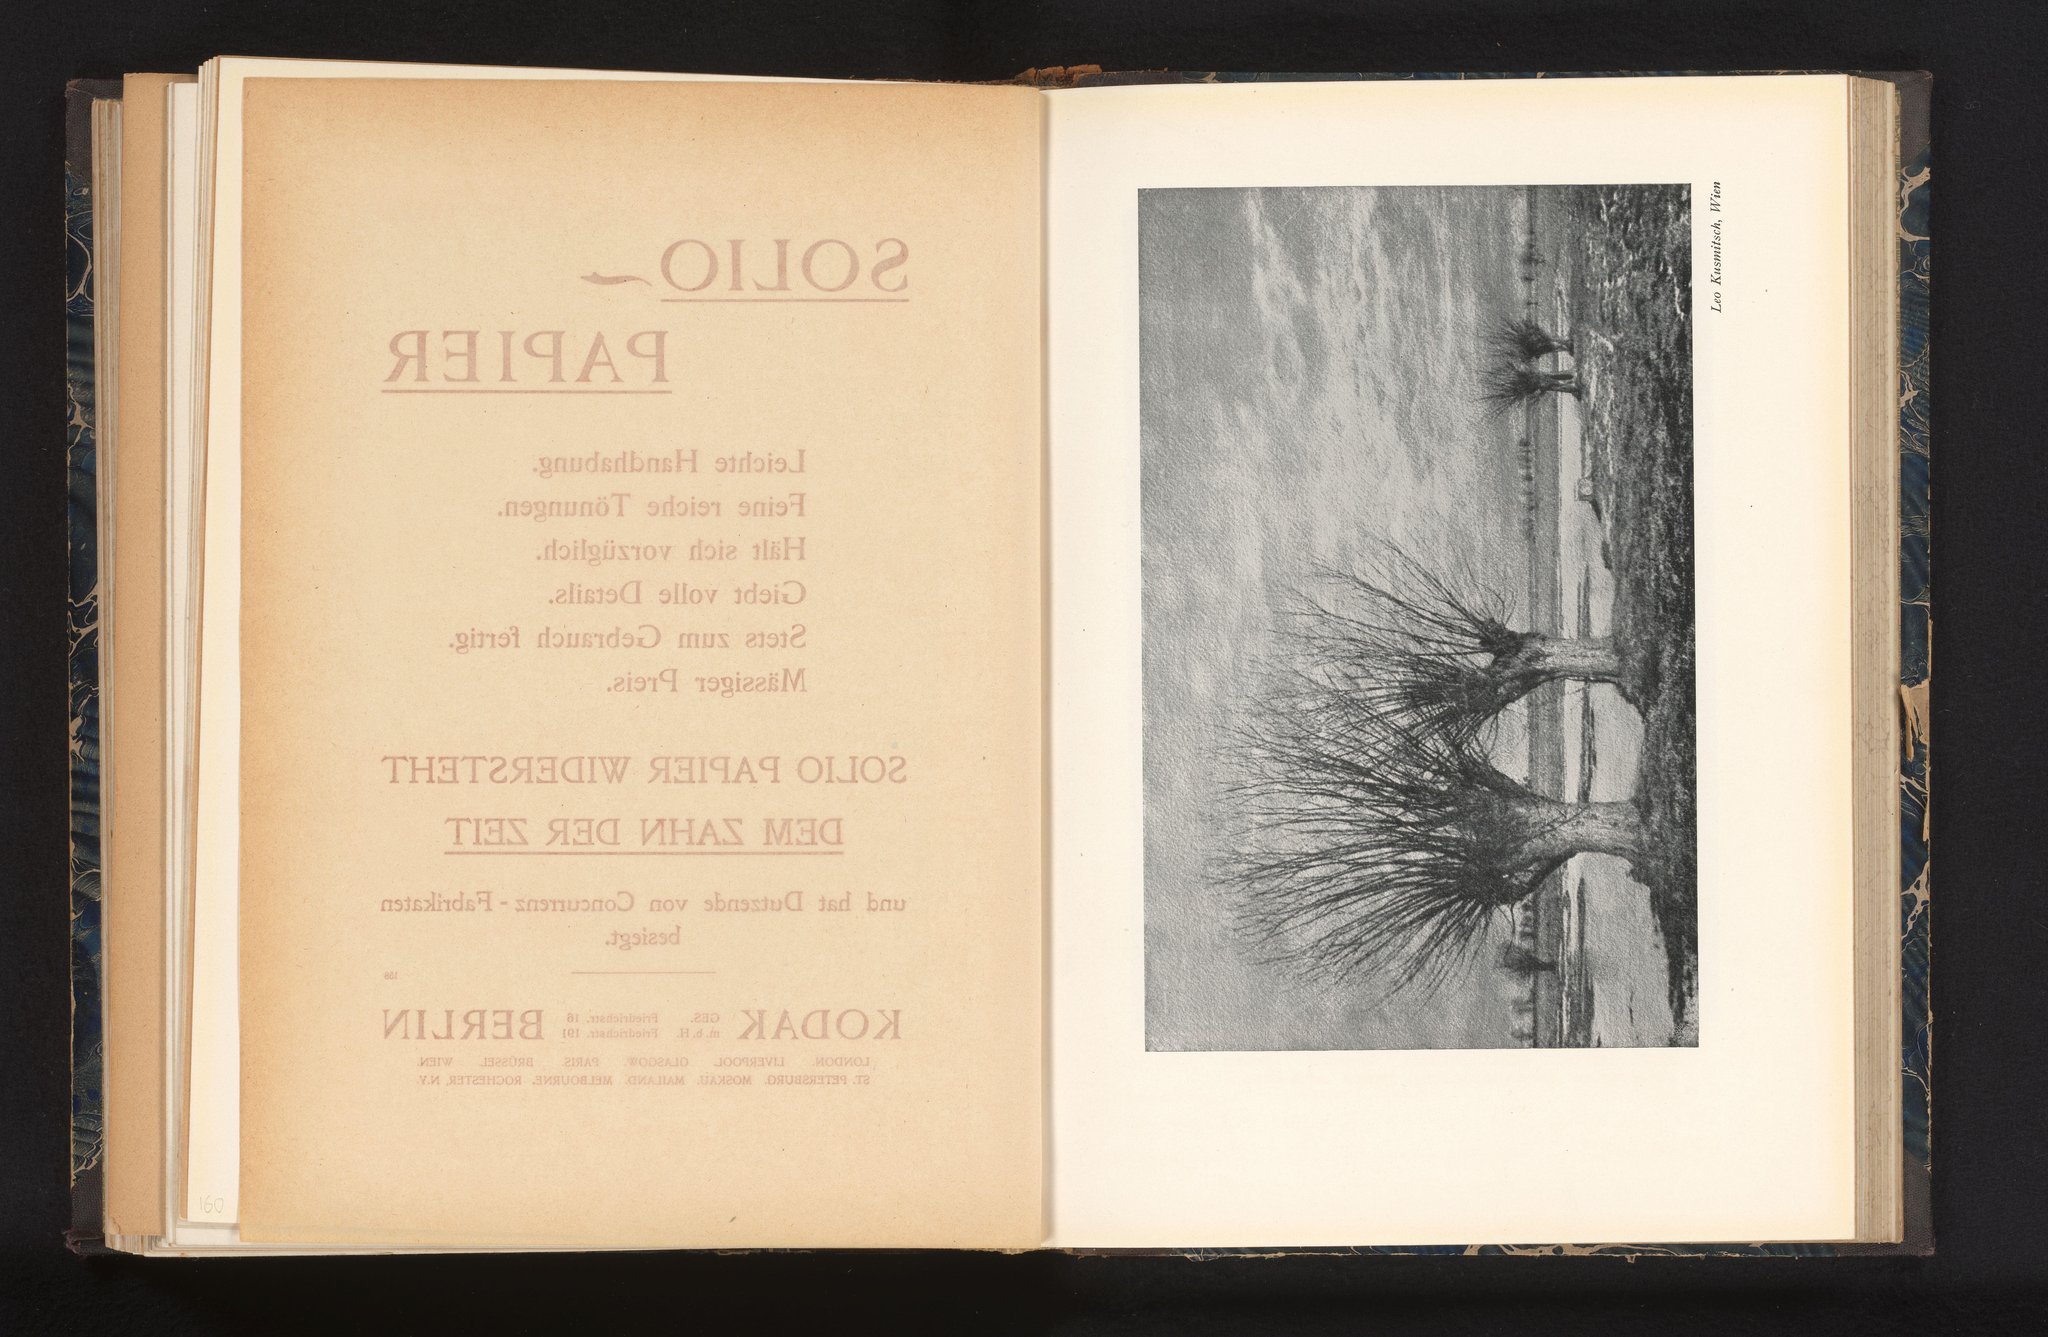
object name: photomechanical print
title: Gezicht op een aantal bomen aan een water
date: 1897-1902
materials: paper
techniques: autotype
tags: trees, landscapes with waters, waterscapes, seascapes (in the temperate zone)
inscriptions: monogram: ‘Leipzig/ S.G.’